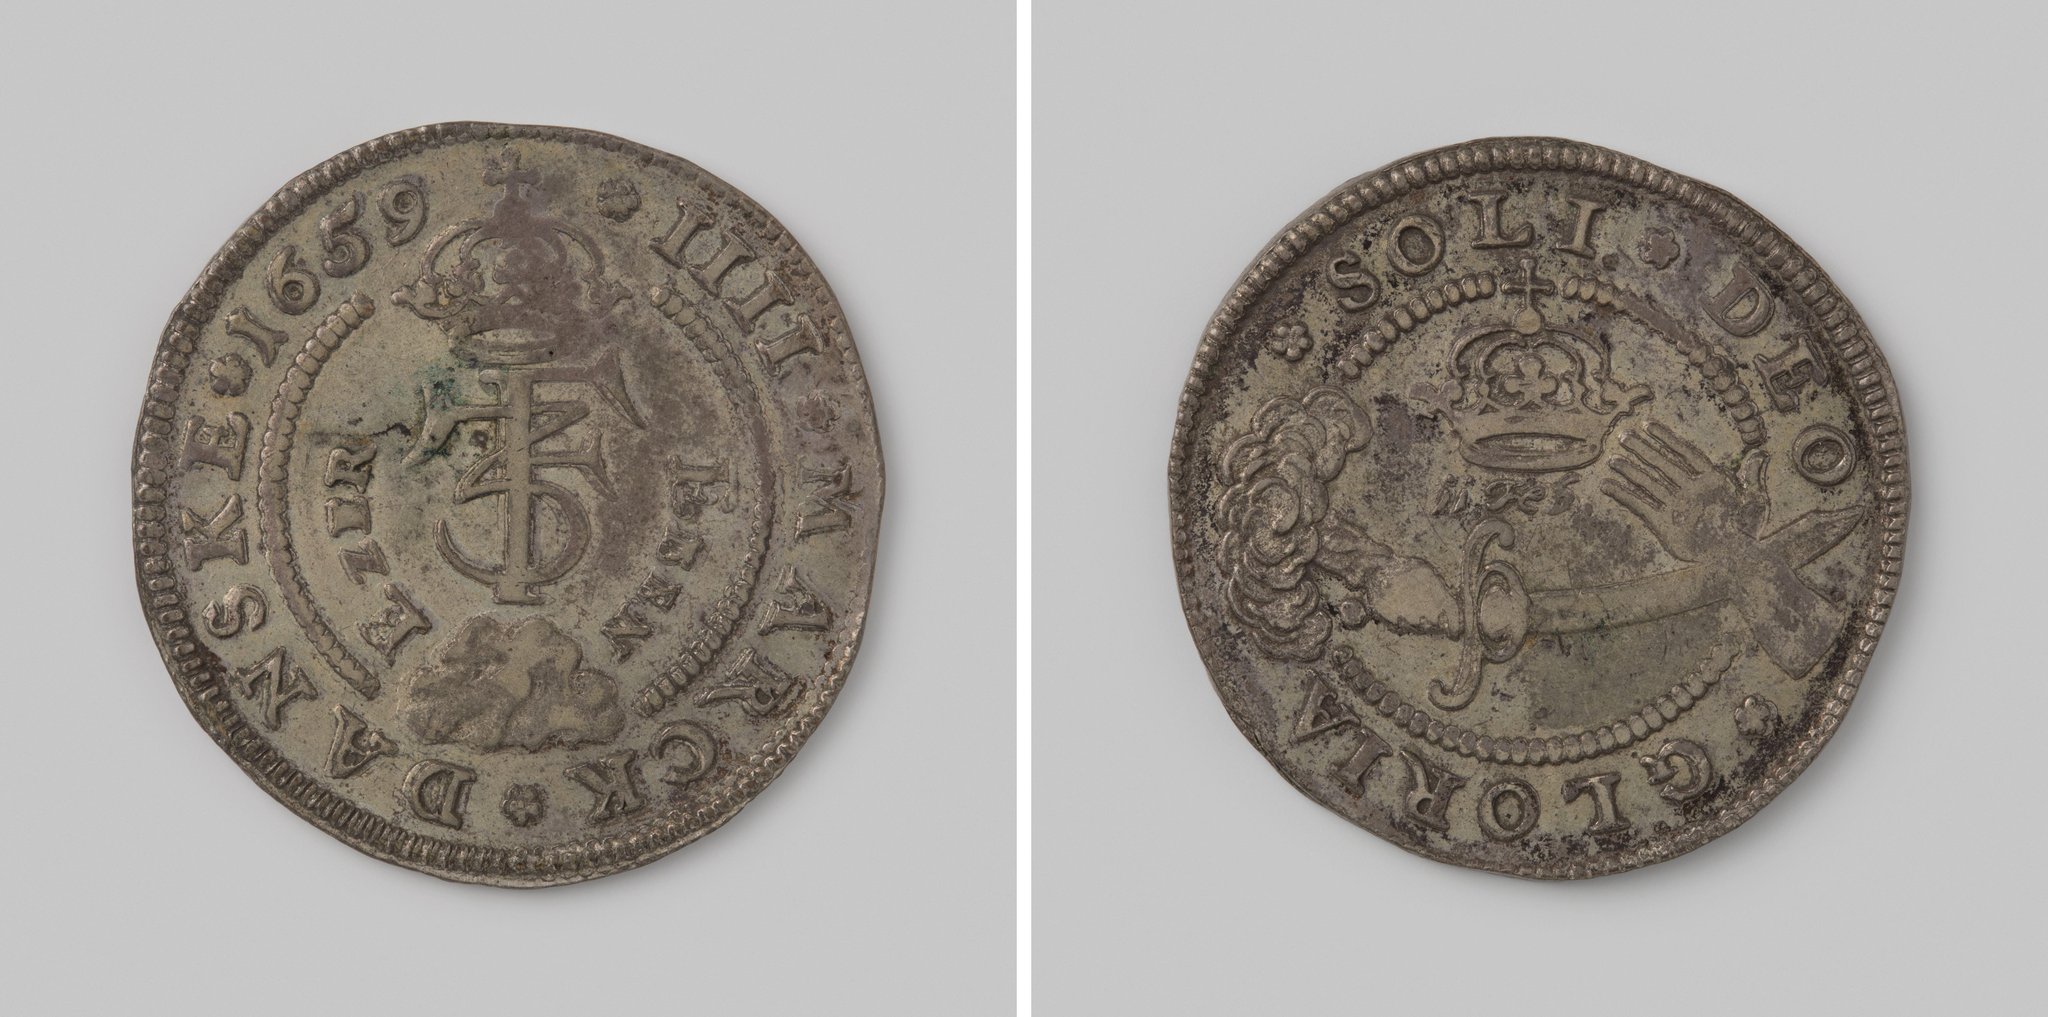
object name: coin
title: 4 mark danske uit Denemarken van Frederik III, 1659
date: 1659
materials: silver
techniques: striking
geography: copenhagen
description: Zilveren munt. Voorzijde: tussen aanduiding: Eben Ezer bergrug, waarop gekroond monogram van de koning. Waarde-aanduiding in omschrift. Jaartal bovenaan aan het eind van het omschrift. Keerzijde: hand uit wolk met zwaard doorsnijdt andere hand die naar kroon reikt. Onder kroon aanduiding: ii Feb. Gladde rand.